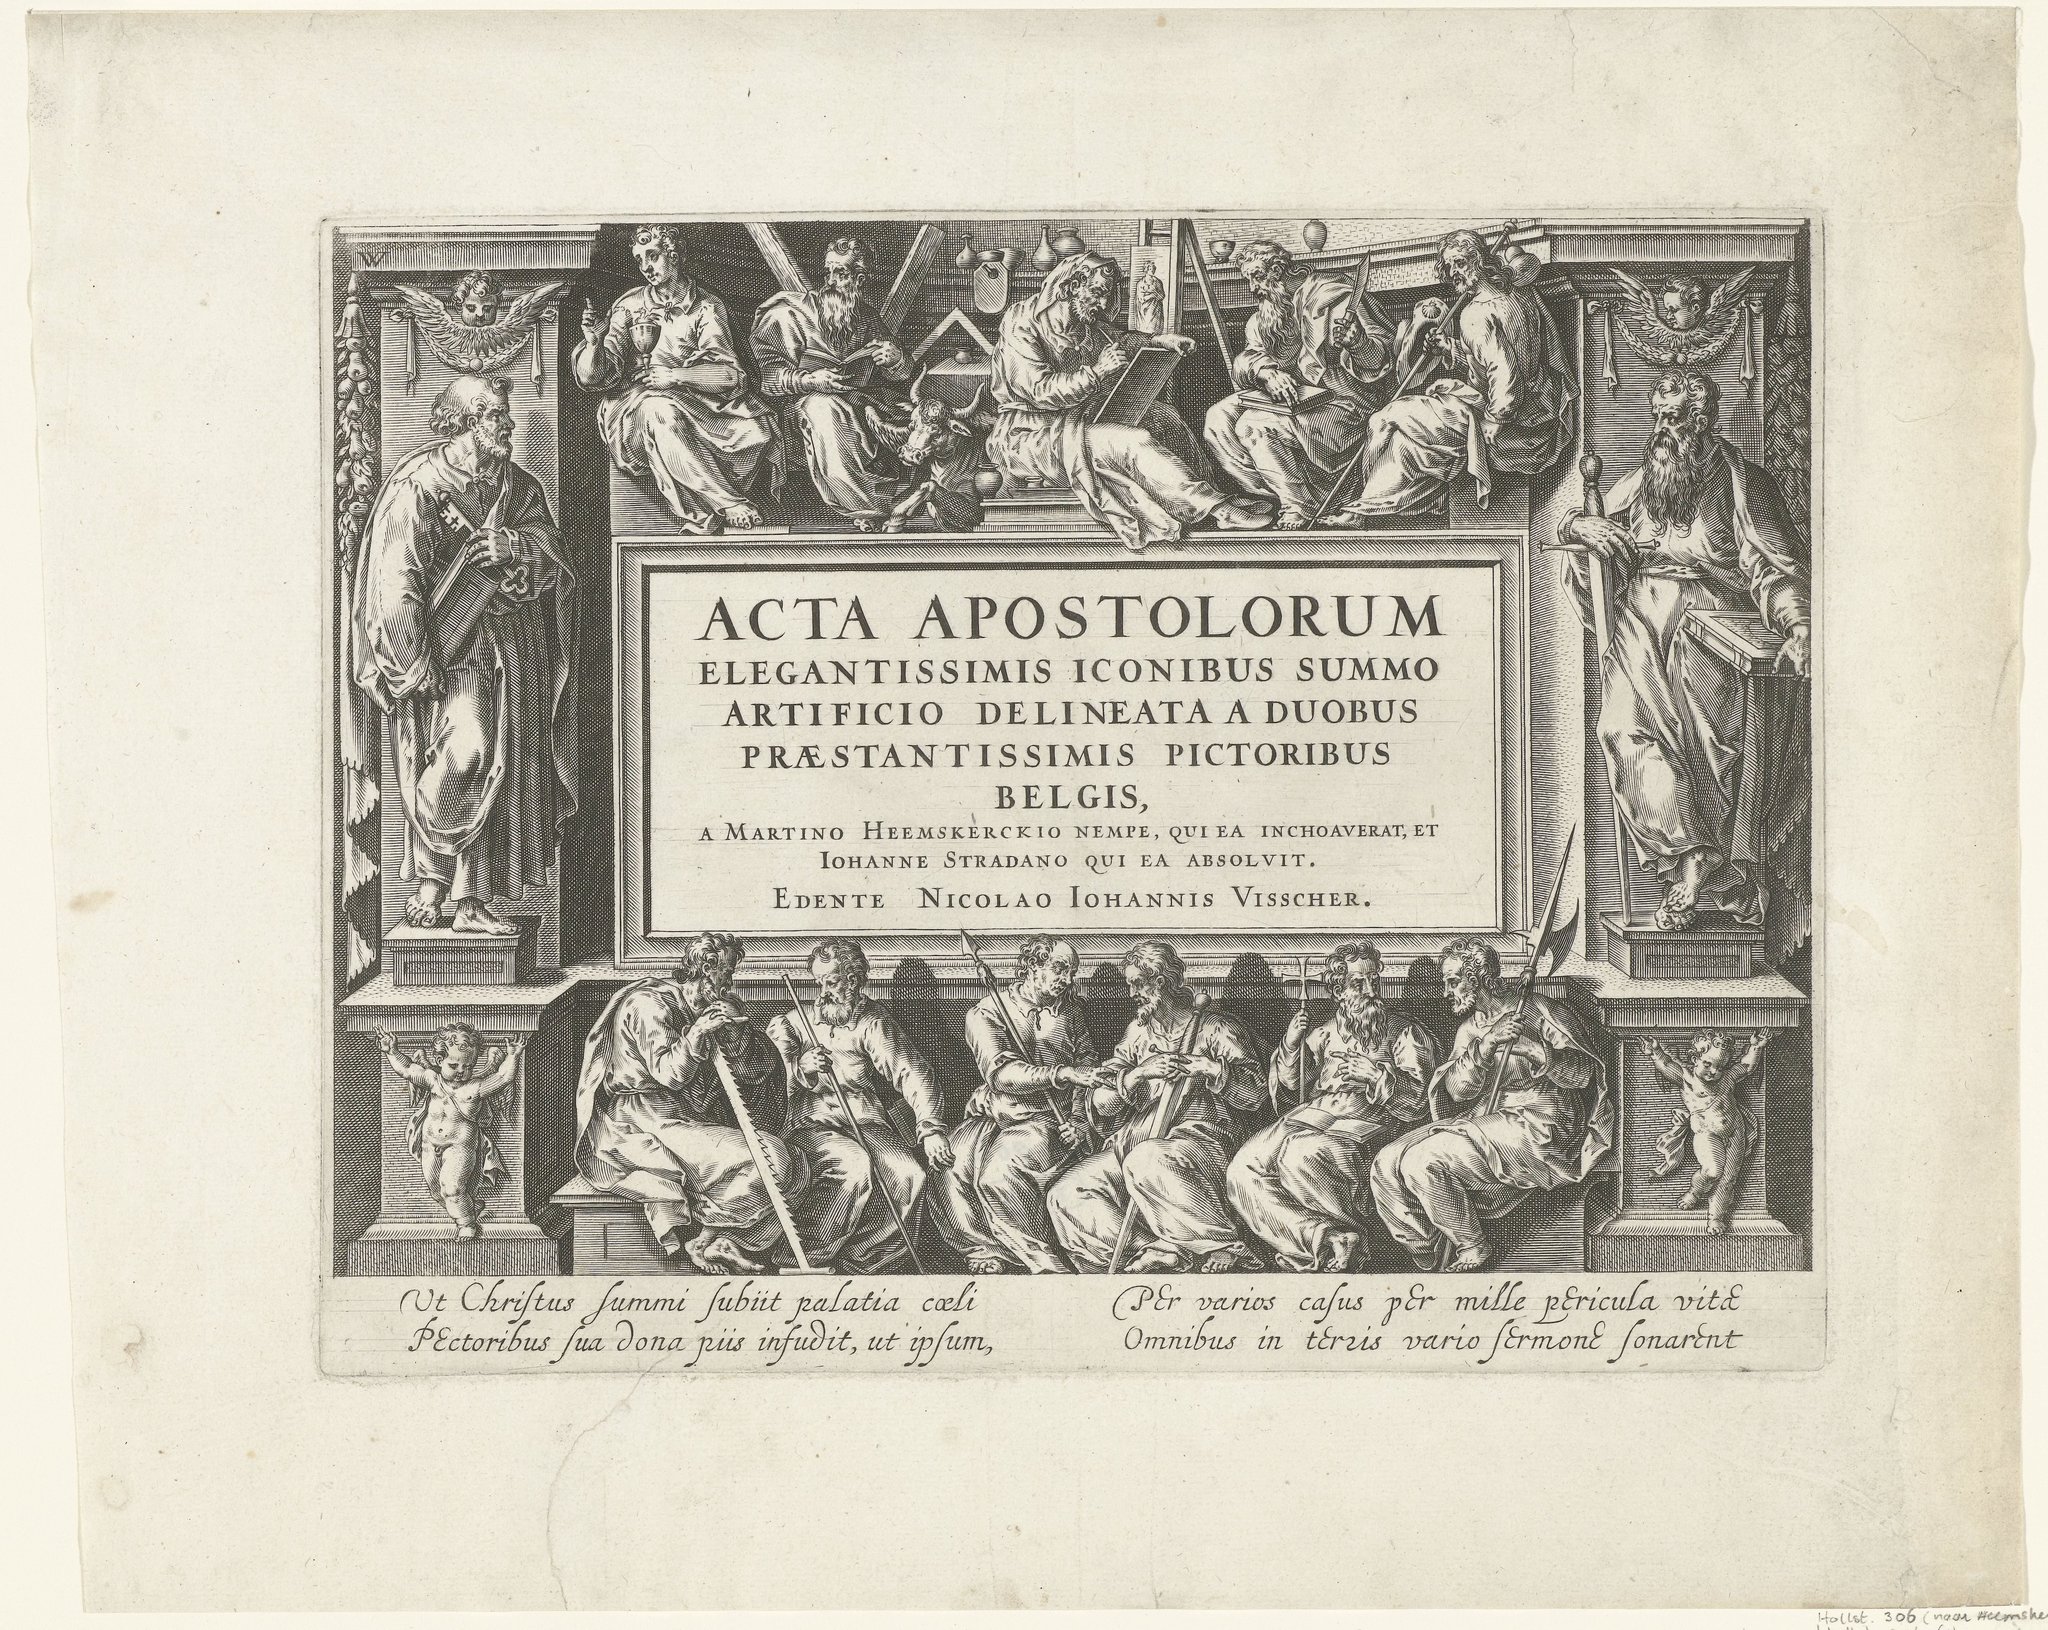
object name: print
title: Acta Apostolorum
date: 1643-1646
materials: paper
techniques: engraving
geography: amsterdam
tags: the twelve apostles (as a group), usually with books or scrolls (not in biblical context), lives and acts of the apostles (part i)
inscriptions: collector's mark: Lugt 2228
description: Centraal in een kader de titel Acta Apostolorum. Rondom het kader elf apostelen. Links van het kader de apostel Petrus. Rechts van het kader de apostel Paulus. De apostelen zijn afgebeeld met hun attributen. De prent is de titelprent van een 34-delige serie over de Handelingen van de apostelen.